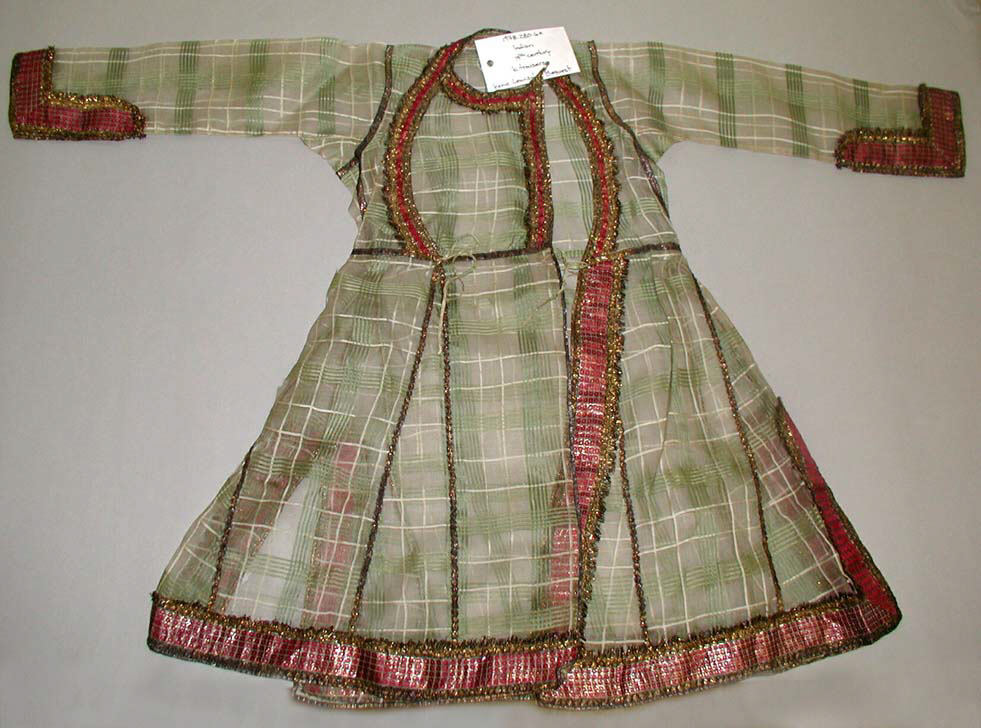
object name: ensemble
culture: indian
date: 1801-1900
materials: metal thread, silk